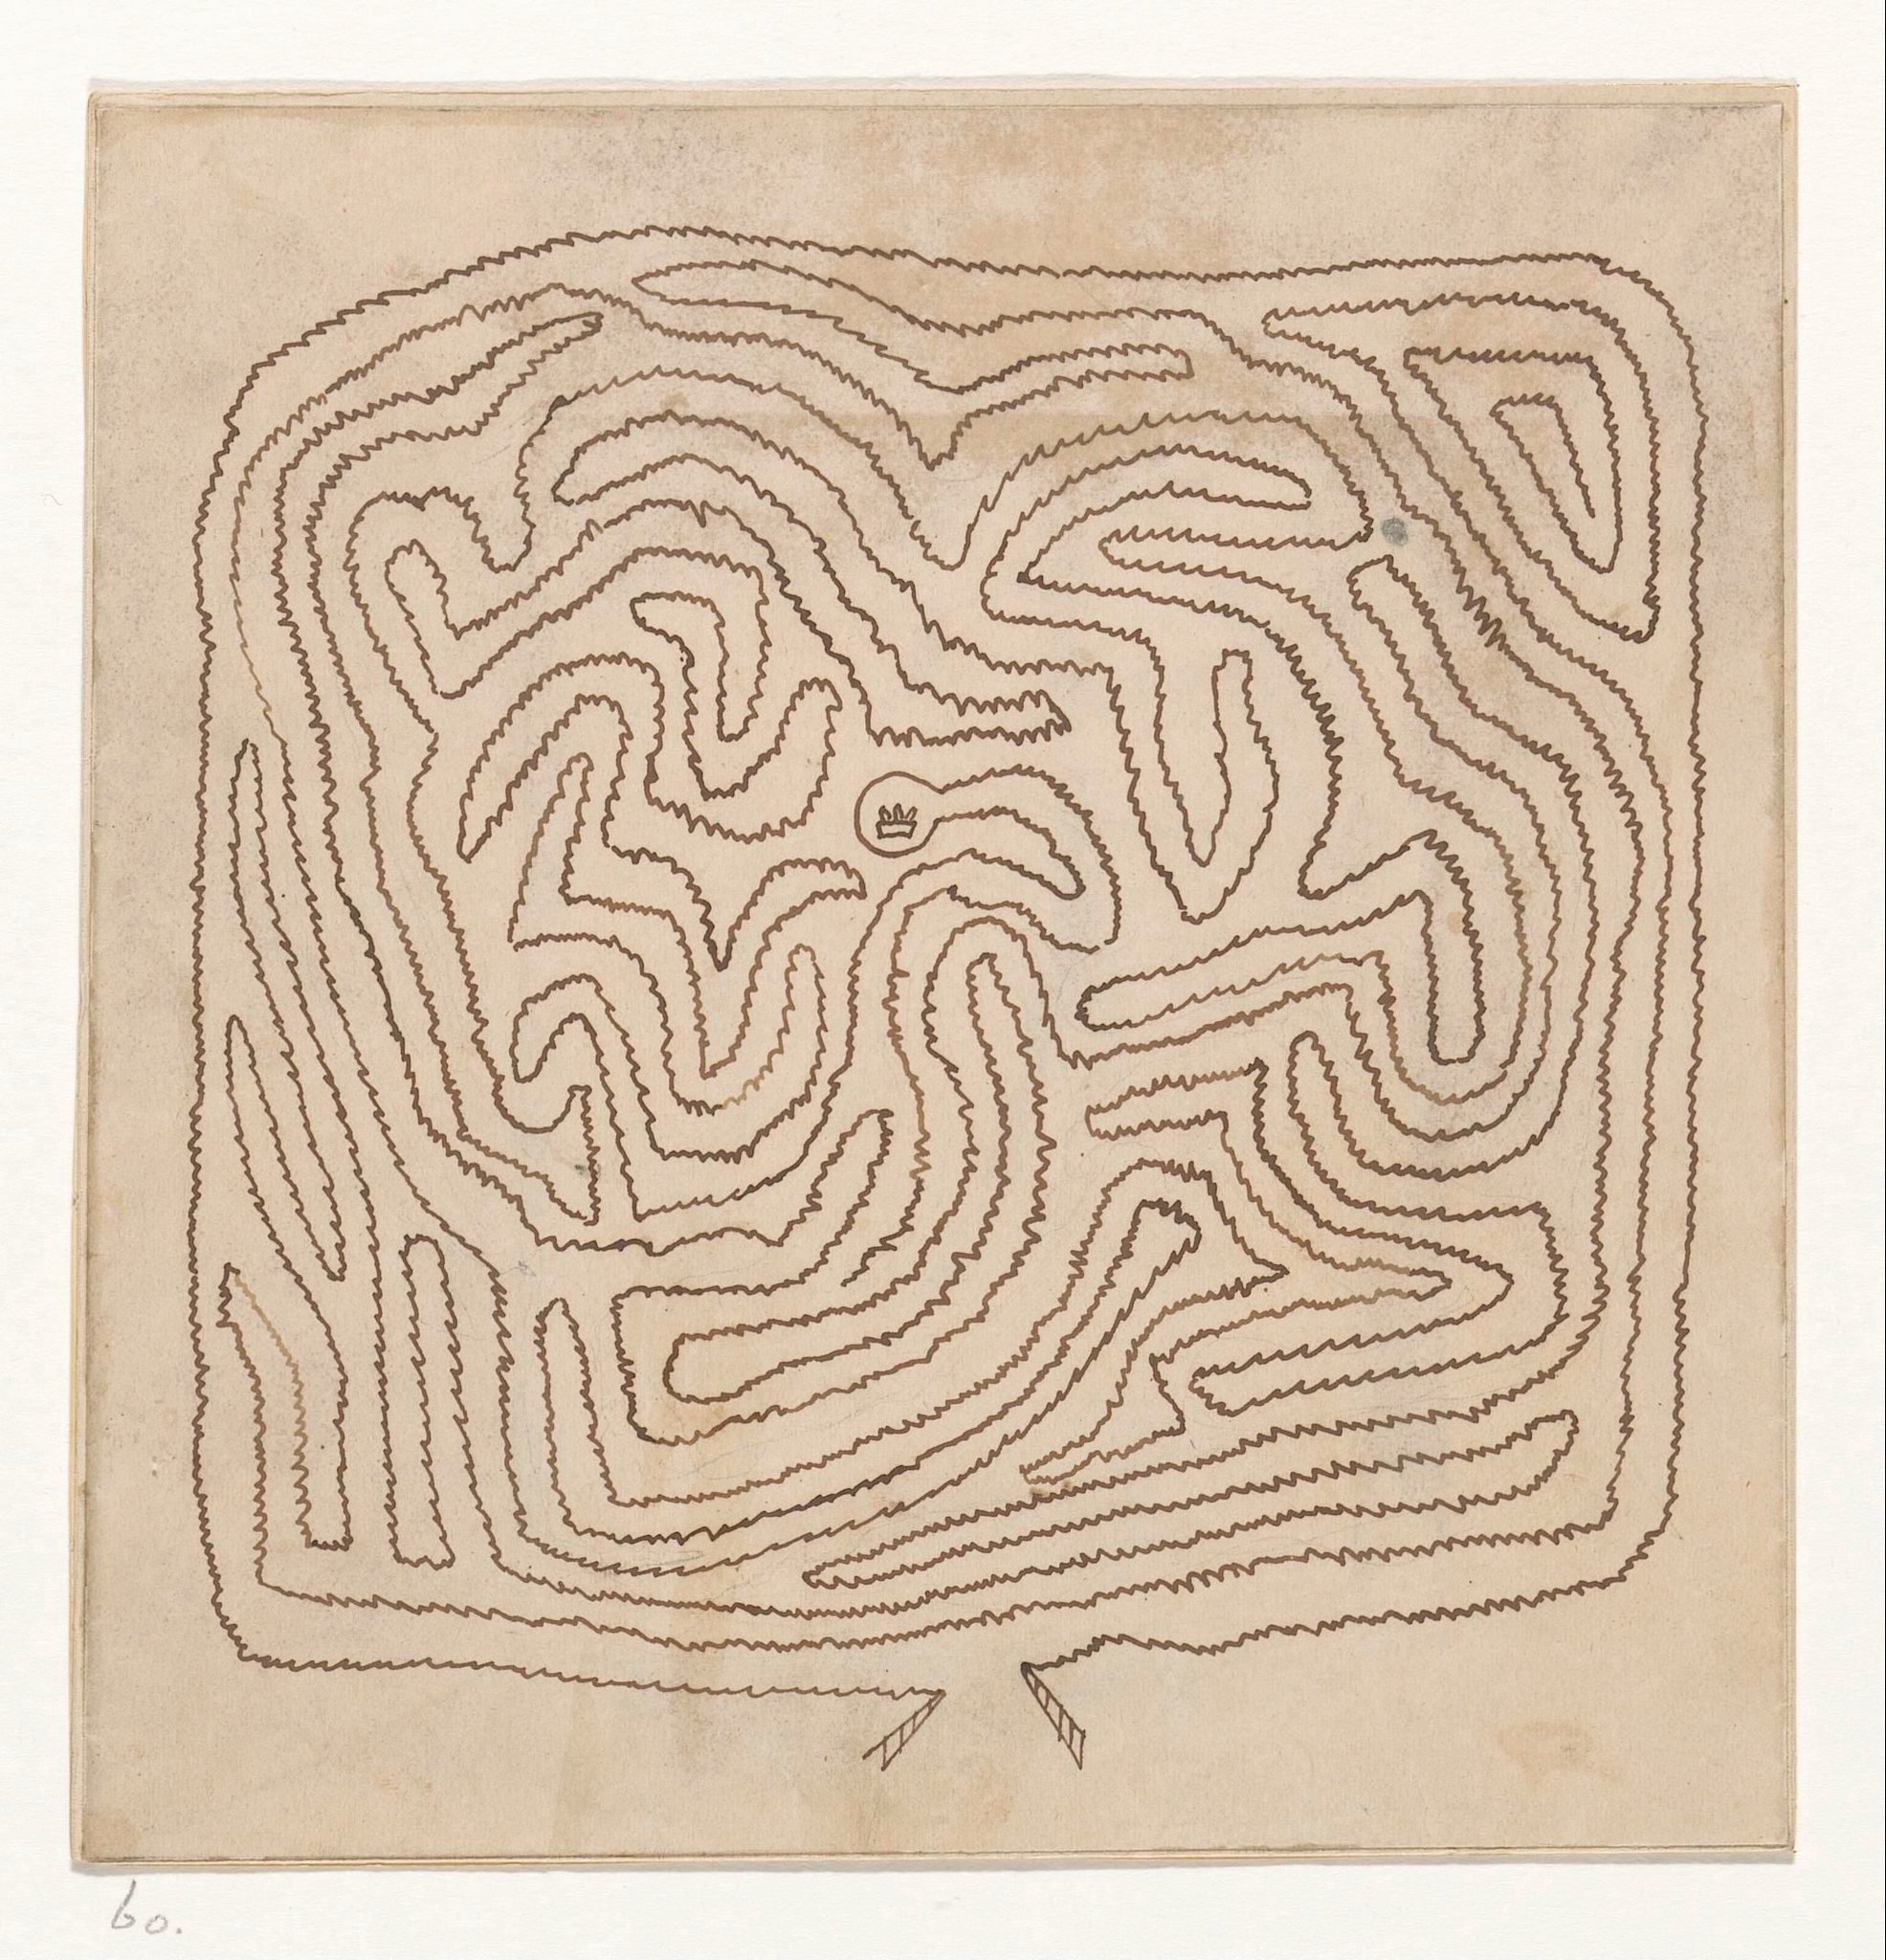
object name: drawing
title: Labyrint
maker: jan brandes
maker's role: draughtsman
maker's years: 1743-1808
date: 1770-1808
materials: cardboard, ink, paper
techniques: pen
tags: labyrinth, maze ~ garden, board-games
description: Vierkant doolhof met in het midden de schat, bij de ingang is een hekje getekend.